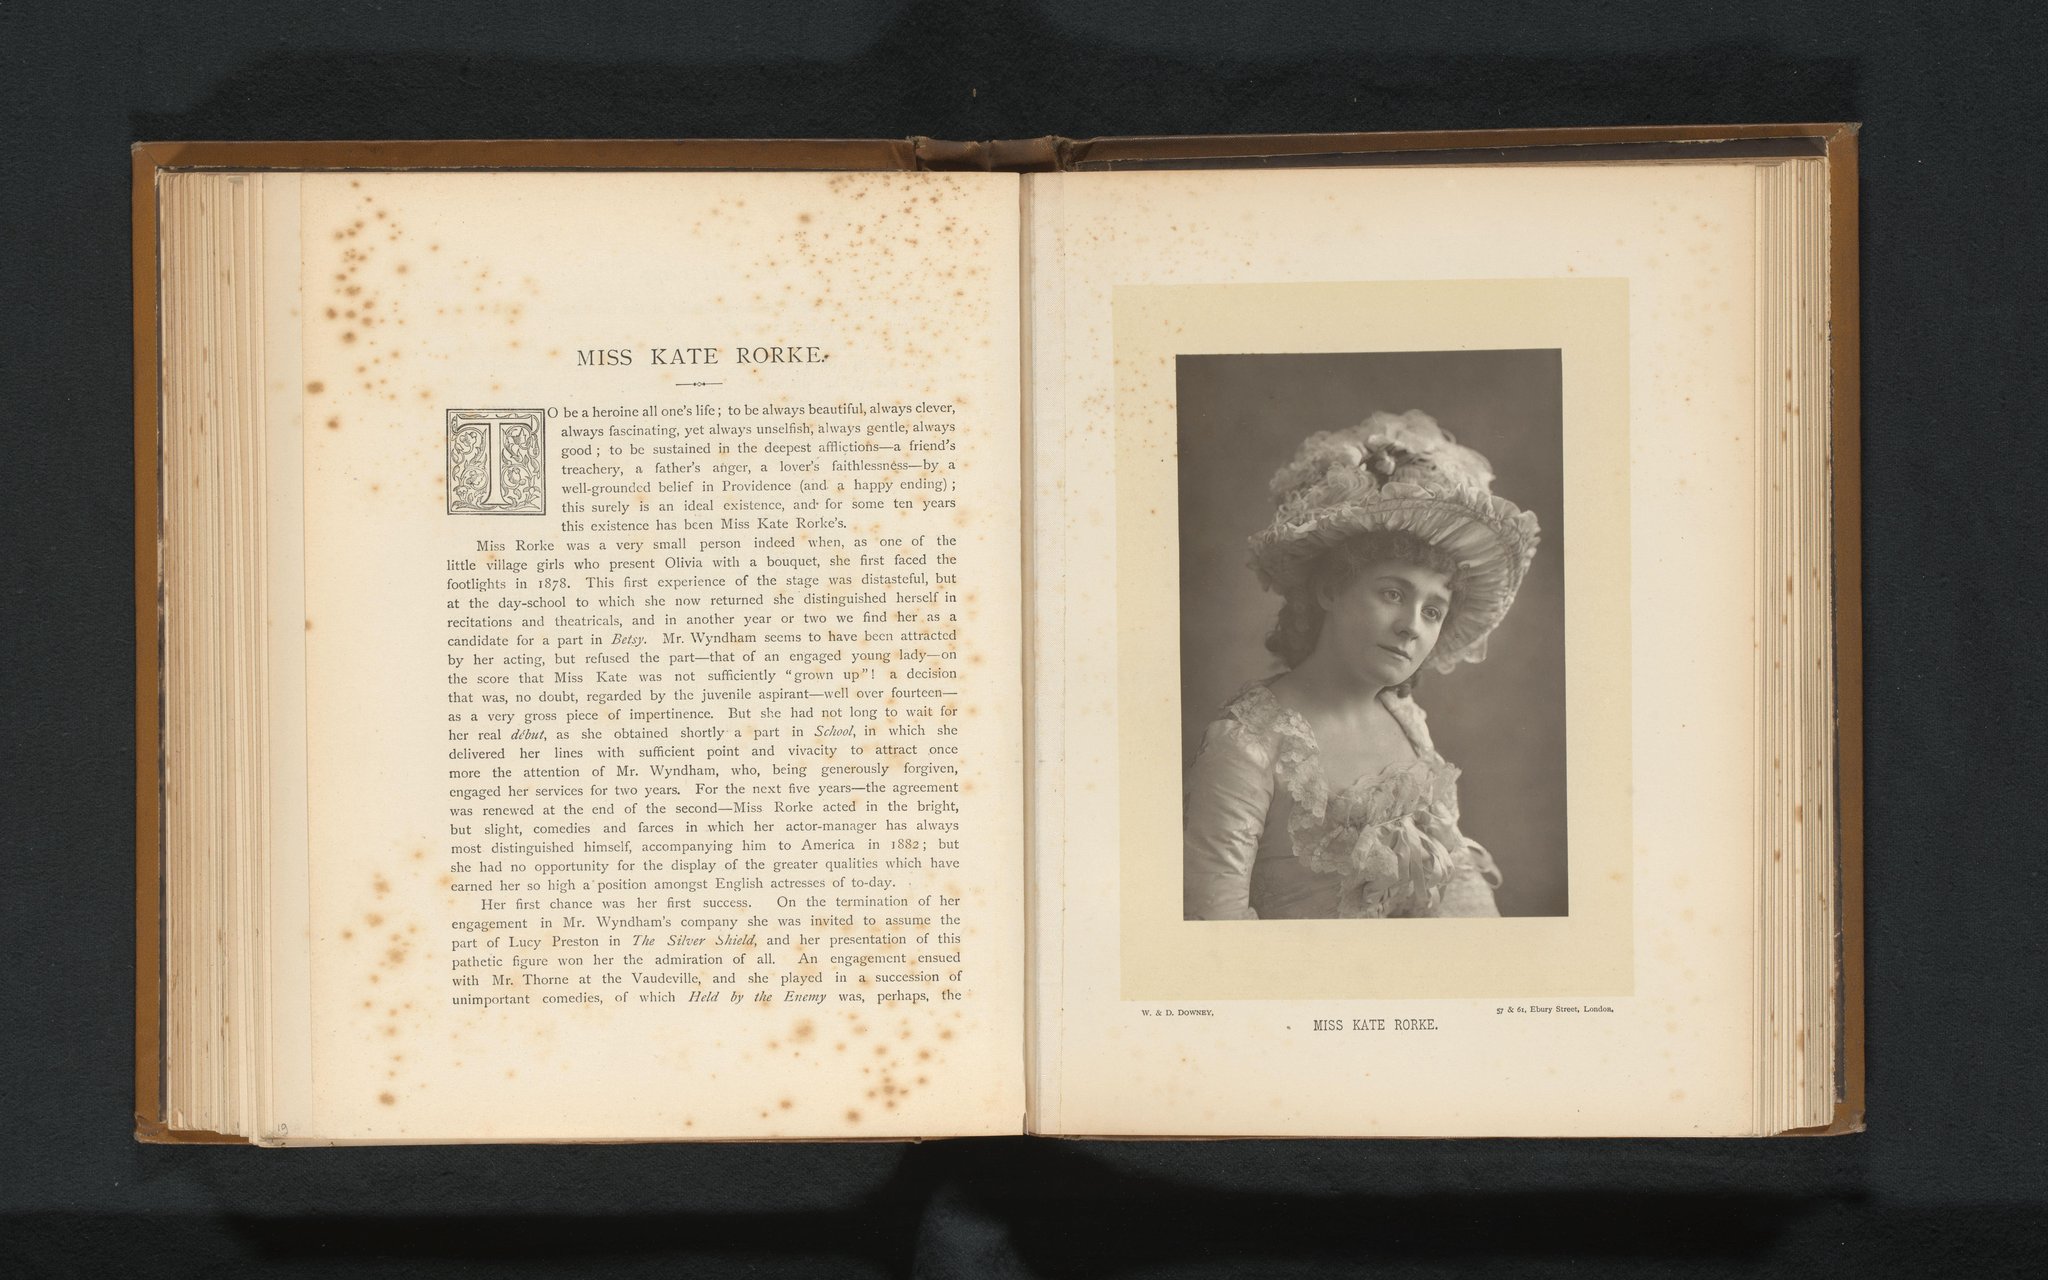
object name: photomechanical print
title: Miss Kate Rorke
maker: Anonymous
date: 1882-1892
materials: paper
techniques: woodburytype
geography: london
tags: portrait of actor, actress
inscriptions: inscription: ‘57 & 61, Elbury Street, London.’